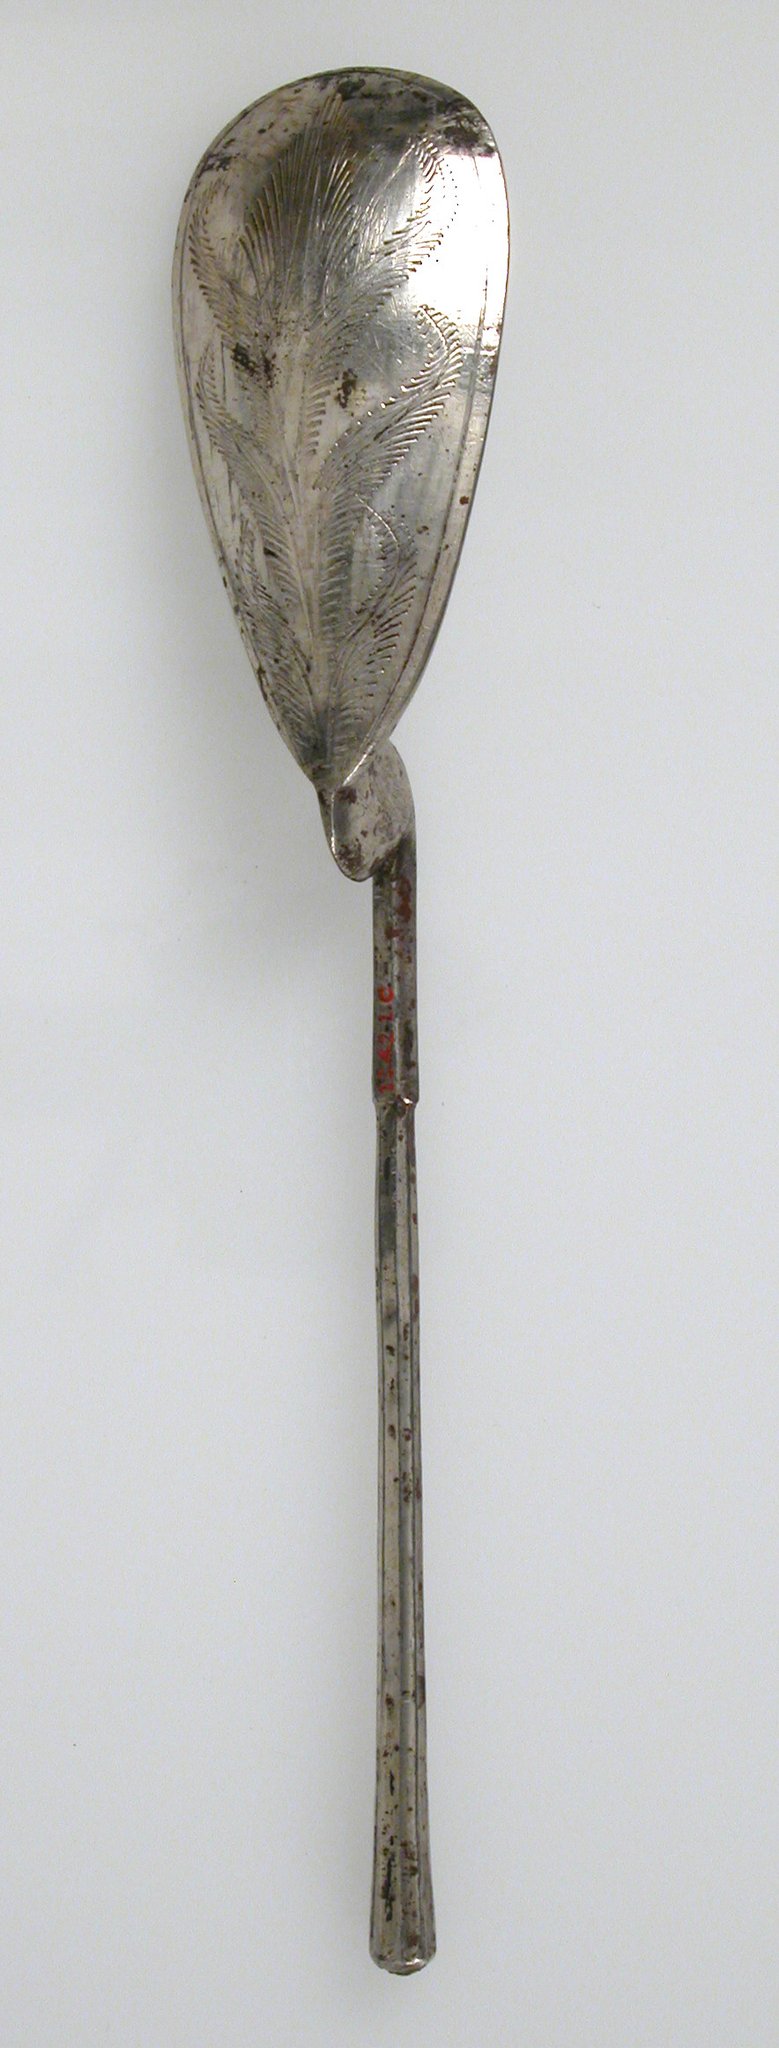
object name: spoon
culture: byzantine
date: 401-600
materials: silver